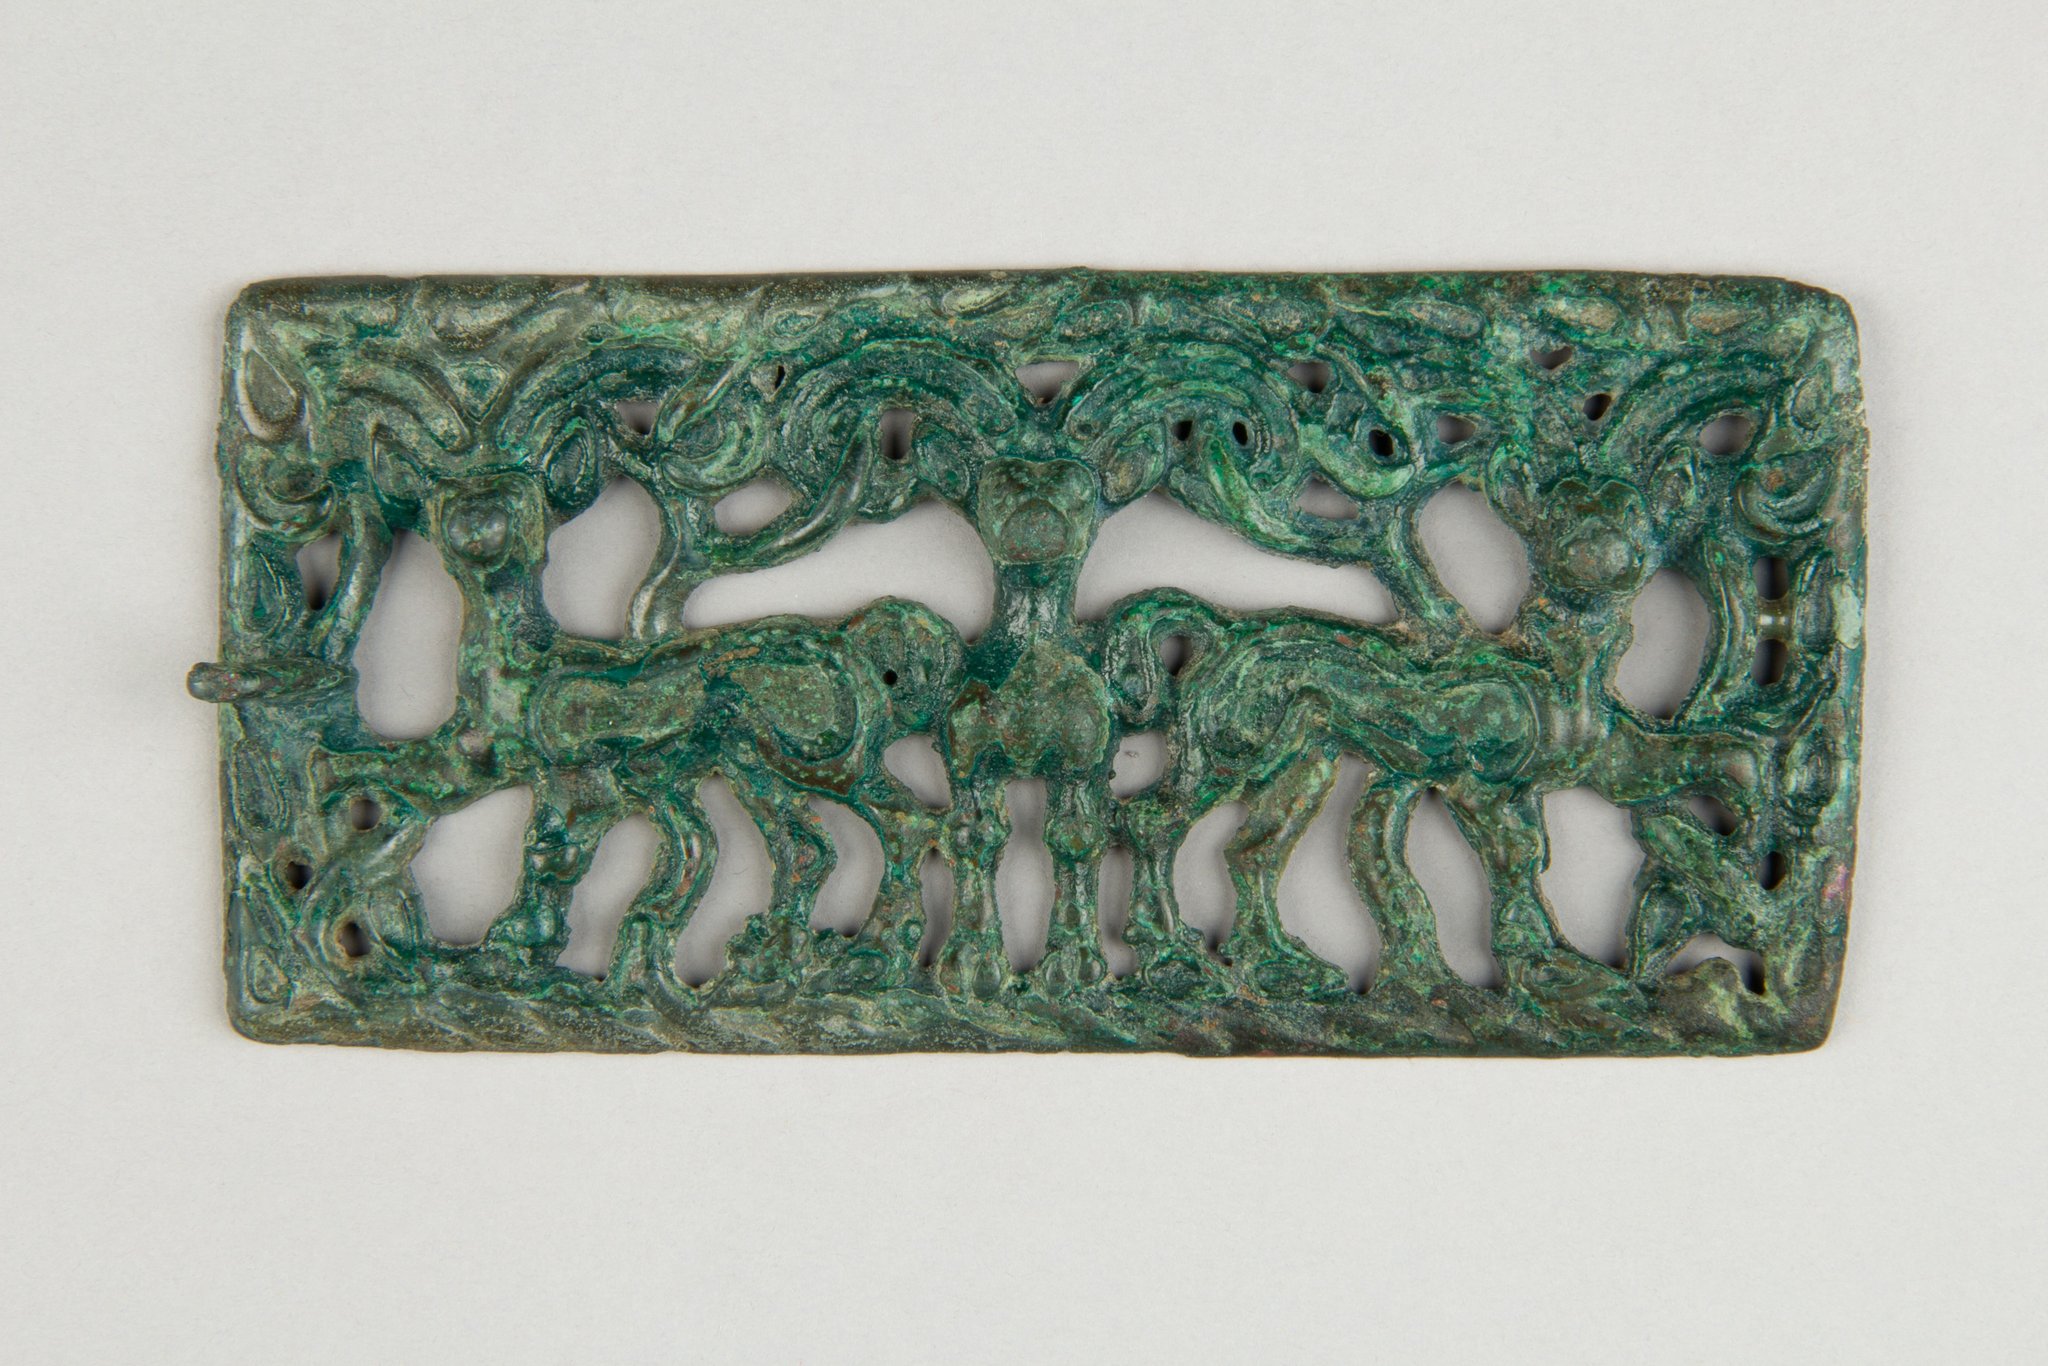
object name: belt plaque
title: Belt Plaque with Three Ibex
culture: northwest chinese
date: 200-1 BCE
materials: bronze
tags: ibex